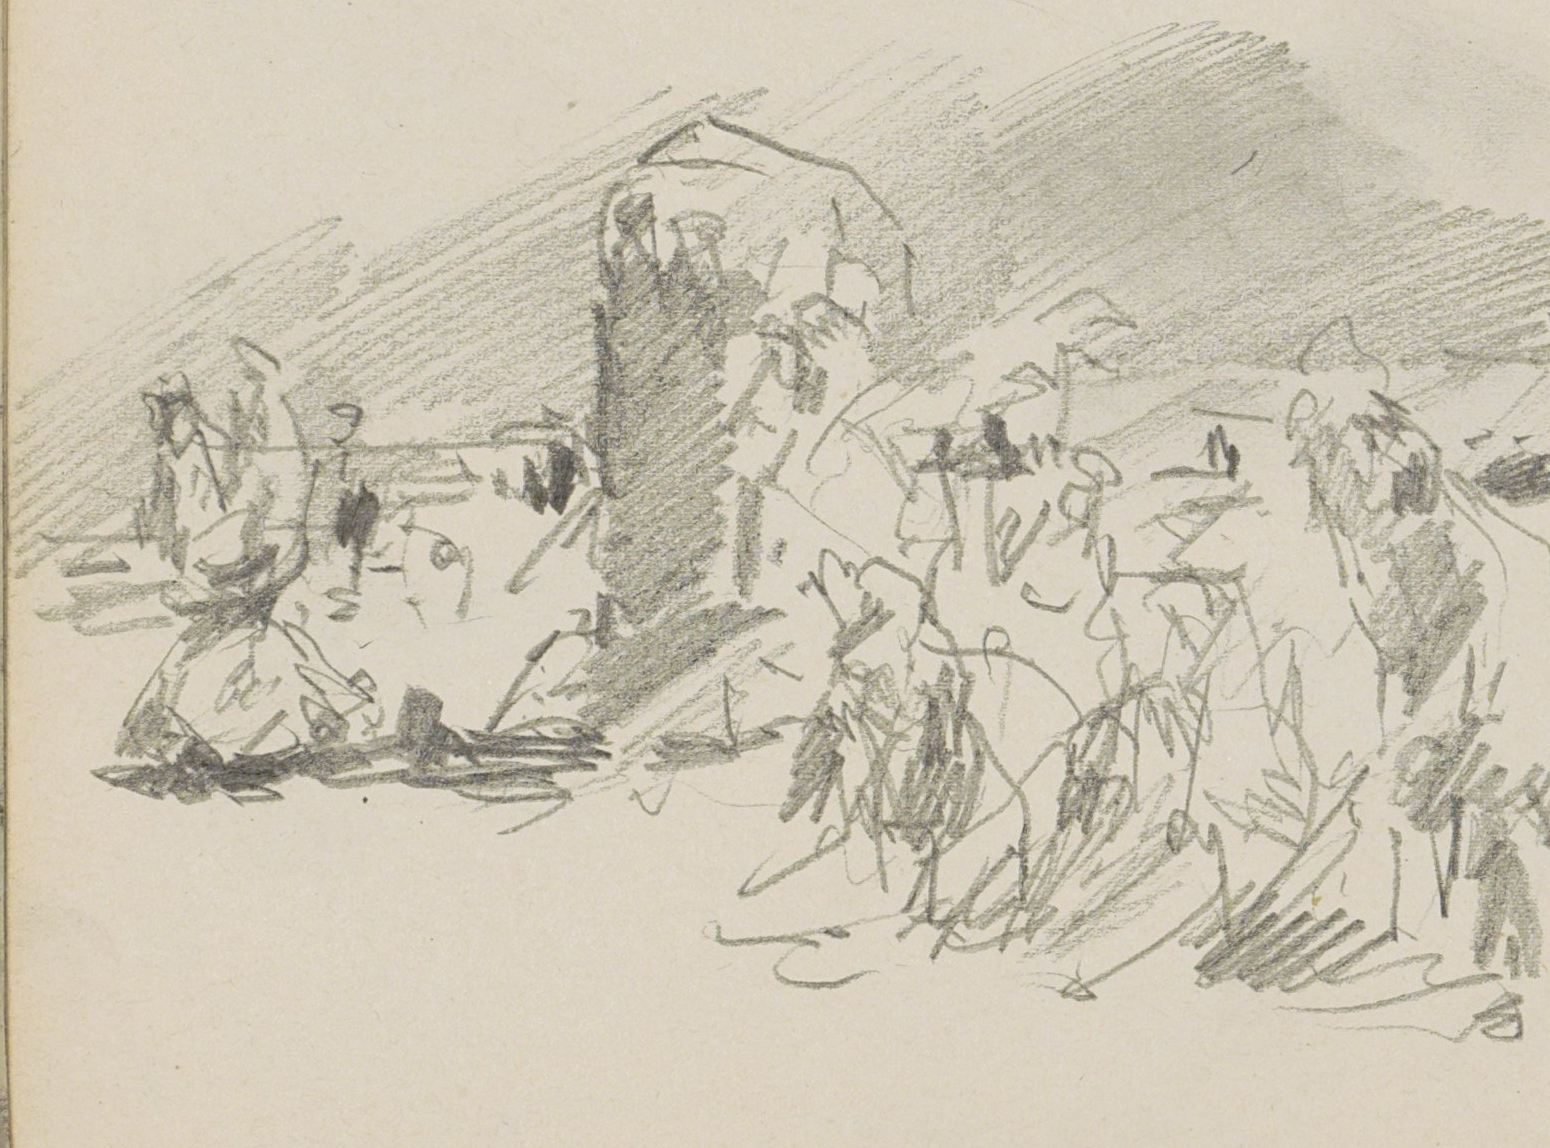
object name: sketchbook leaf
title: Figuren op het strand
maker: johan antonie de jonge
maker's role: draughtsman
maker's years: 1864-1927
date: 1884-1927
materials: paper, pencil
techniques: stumping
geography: south holland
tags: beach (as place of recreation), chair, beach (+ landscape with figures, staffage)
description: Figuren op het strand. Blad 31 verso uit een schetsboek met 33 bladen.